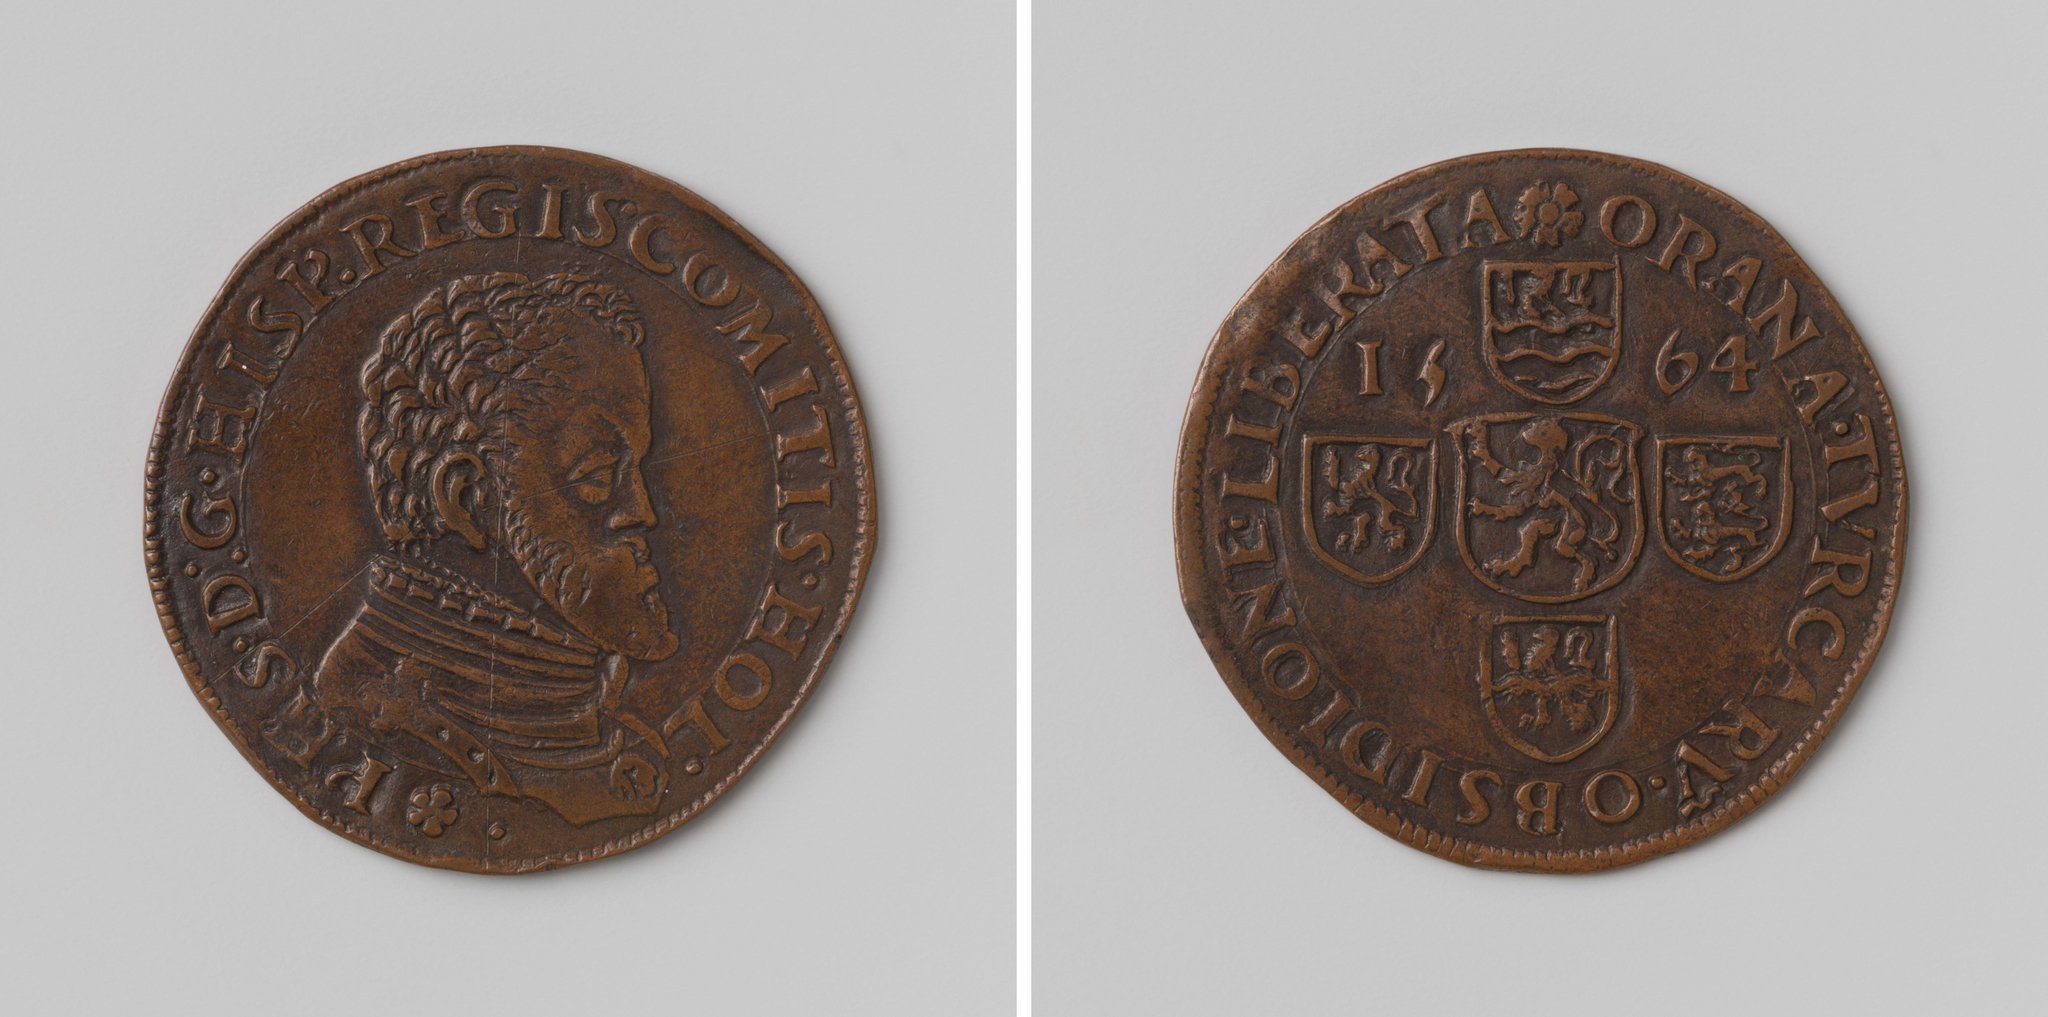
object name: jeton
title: Ontzet van Oran, rekenpenning van de rekenkamer van Holland te 's-Gravenhage, ter ere van Filips II, koning van Spanje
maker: Anonymous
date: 1564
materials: copper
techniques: striking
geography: dordrecht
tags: philip ii of spain, the hague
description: Koperen penning. Voorzijde: borststuk man binnen omschrift. Keerzijde: vijf wapenschilden, waarvan bovenste tussen jaartal binnen omschrift